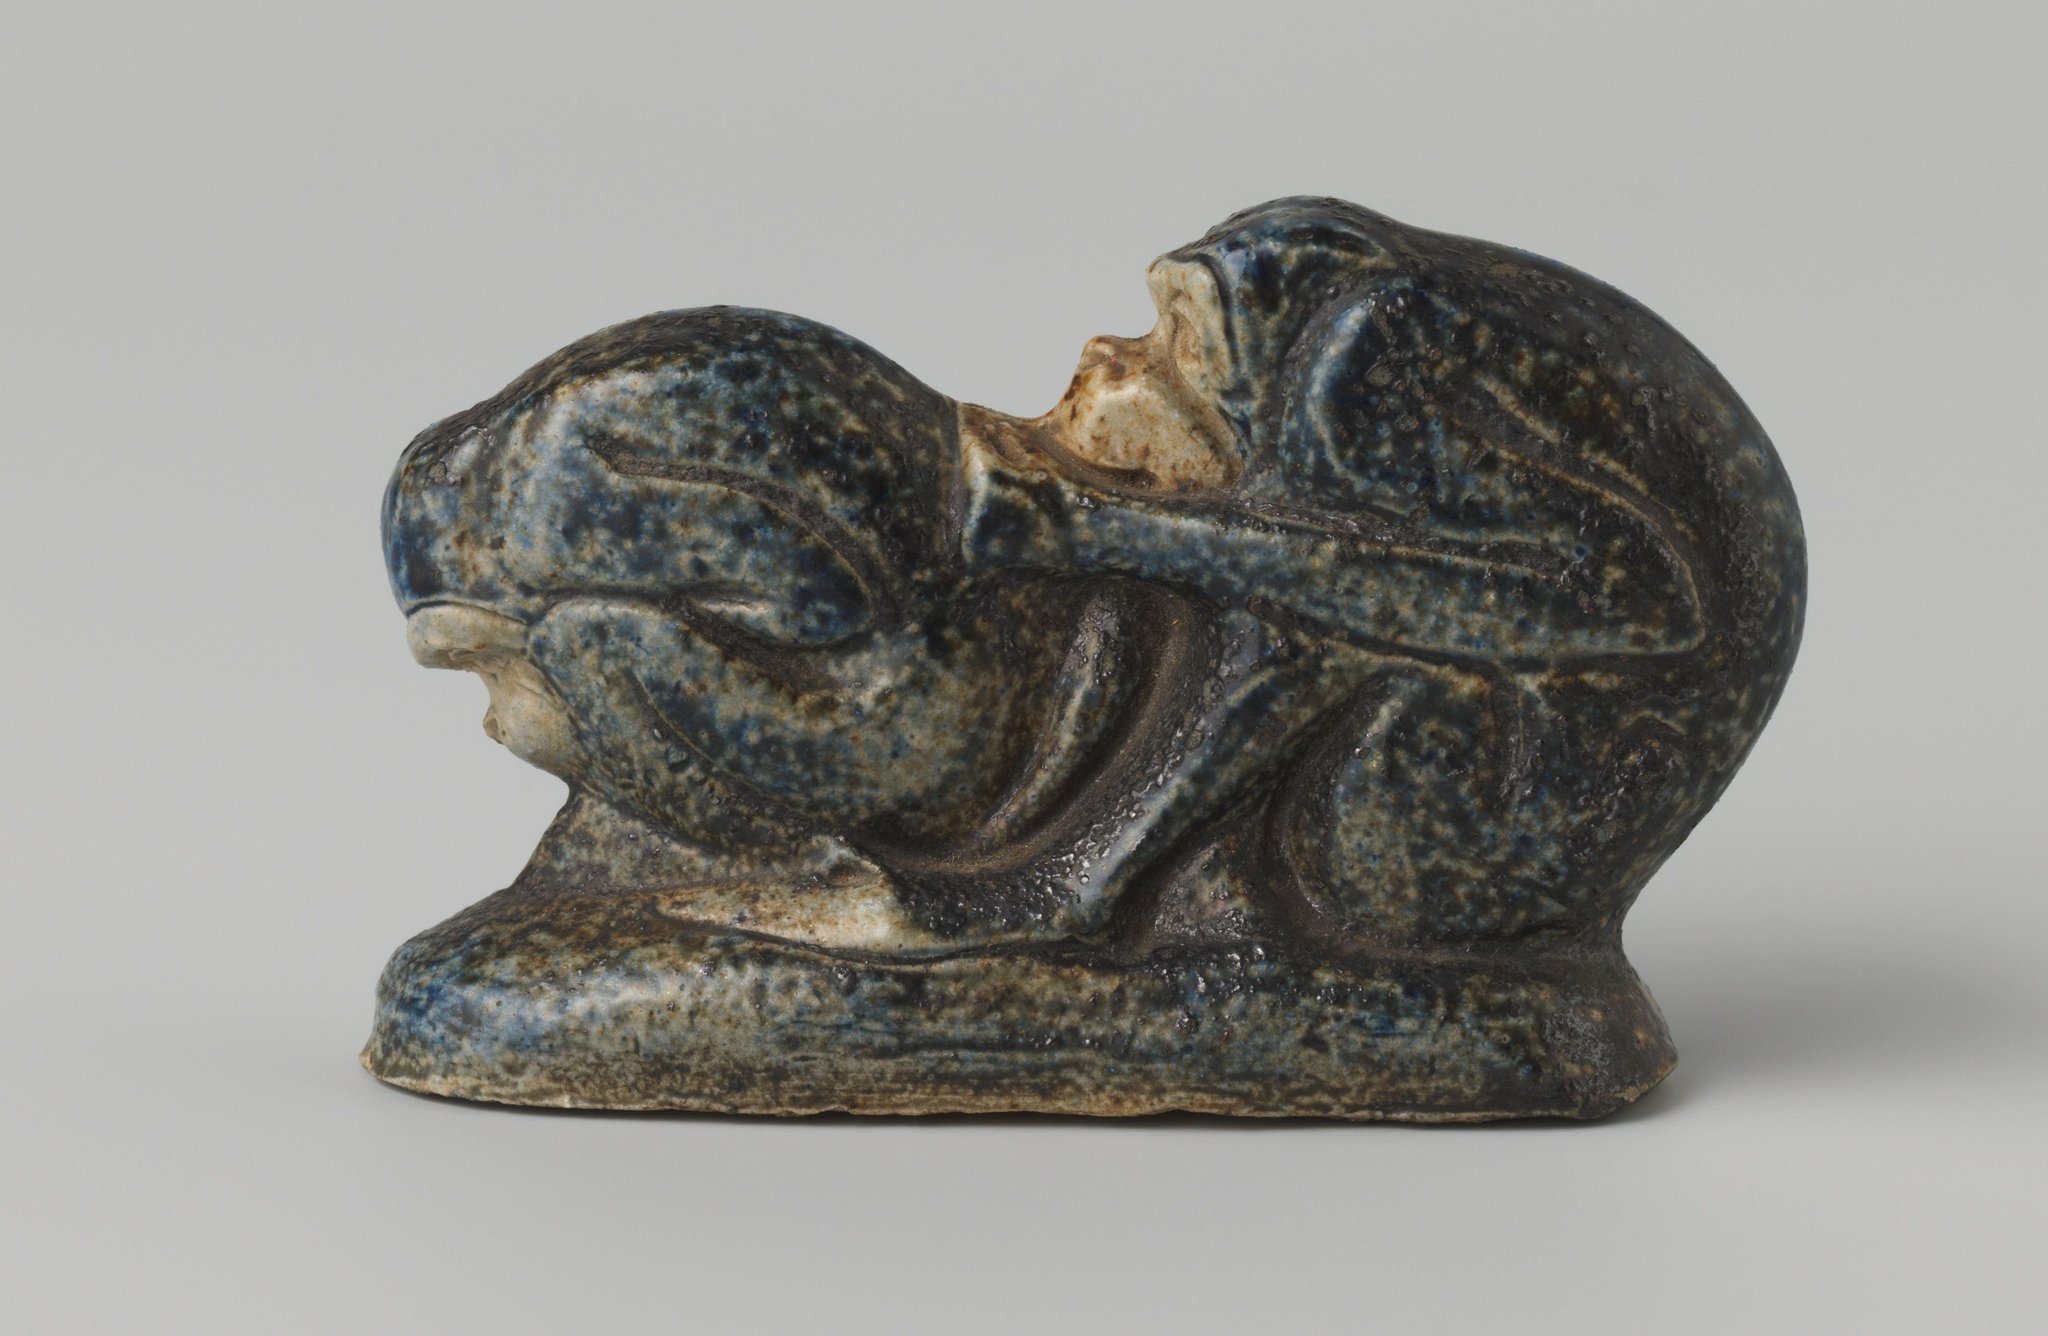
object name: decoratief object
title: Plastiek in de vorm van twee elkaar vlooiende apen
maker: joseph mendes da costa (1863-1939)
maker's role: print maker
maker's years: 1863-1939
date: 1900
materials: earthenware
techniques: painted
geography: netherlands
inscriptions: monogram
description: Plastiek van aardewerk, beschilderd in blauw, in de vorm van twee elkaar vlooiende apen.